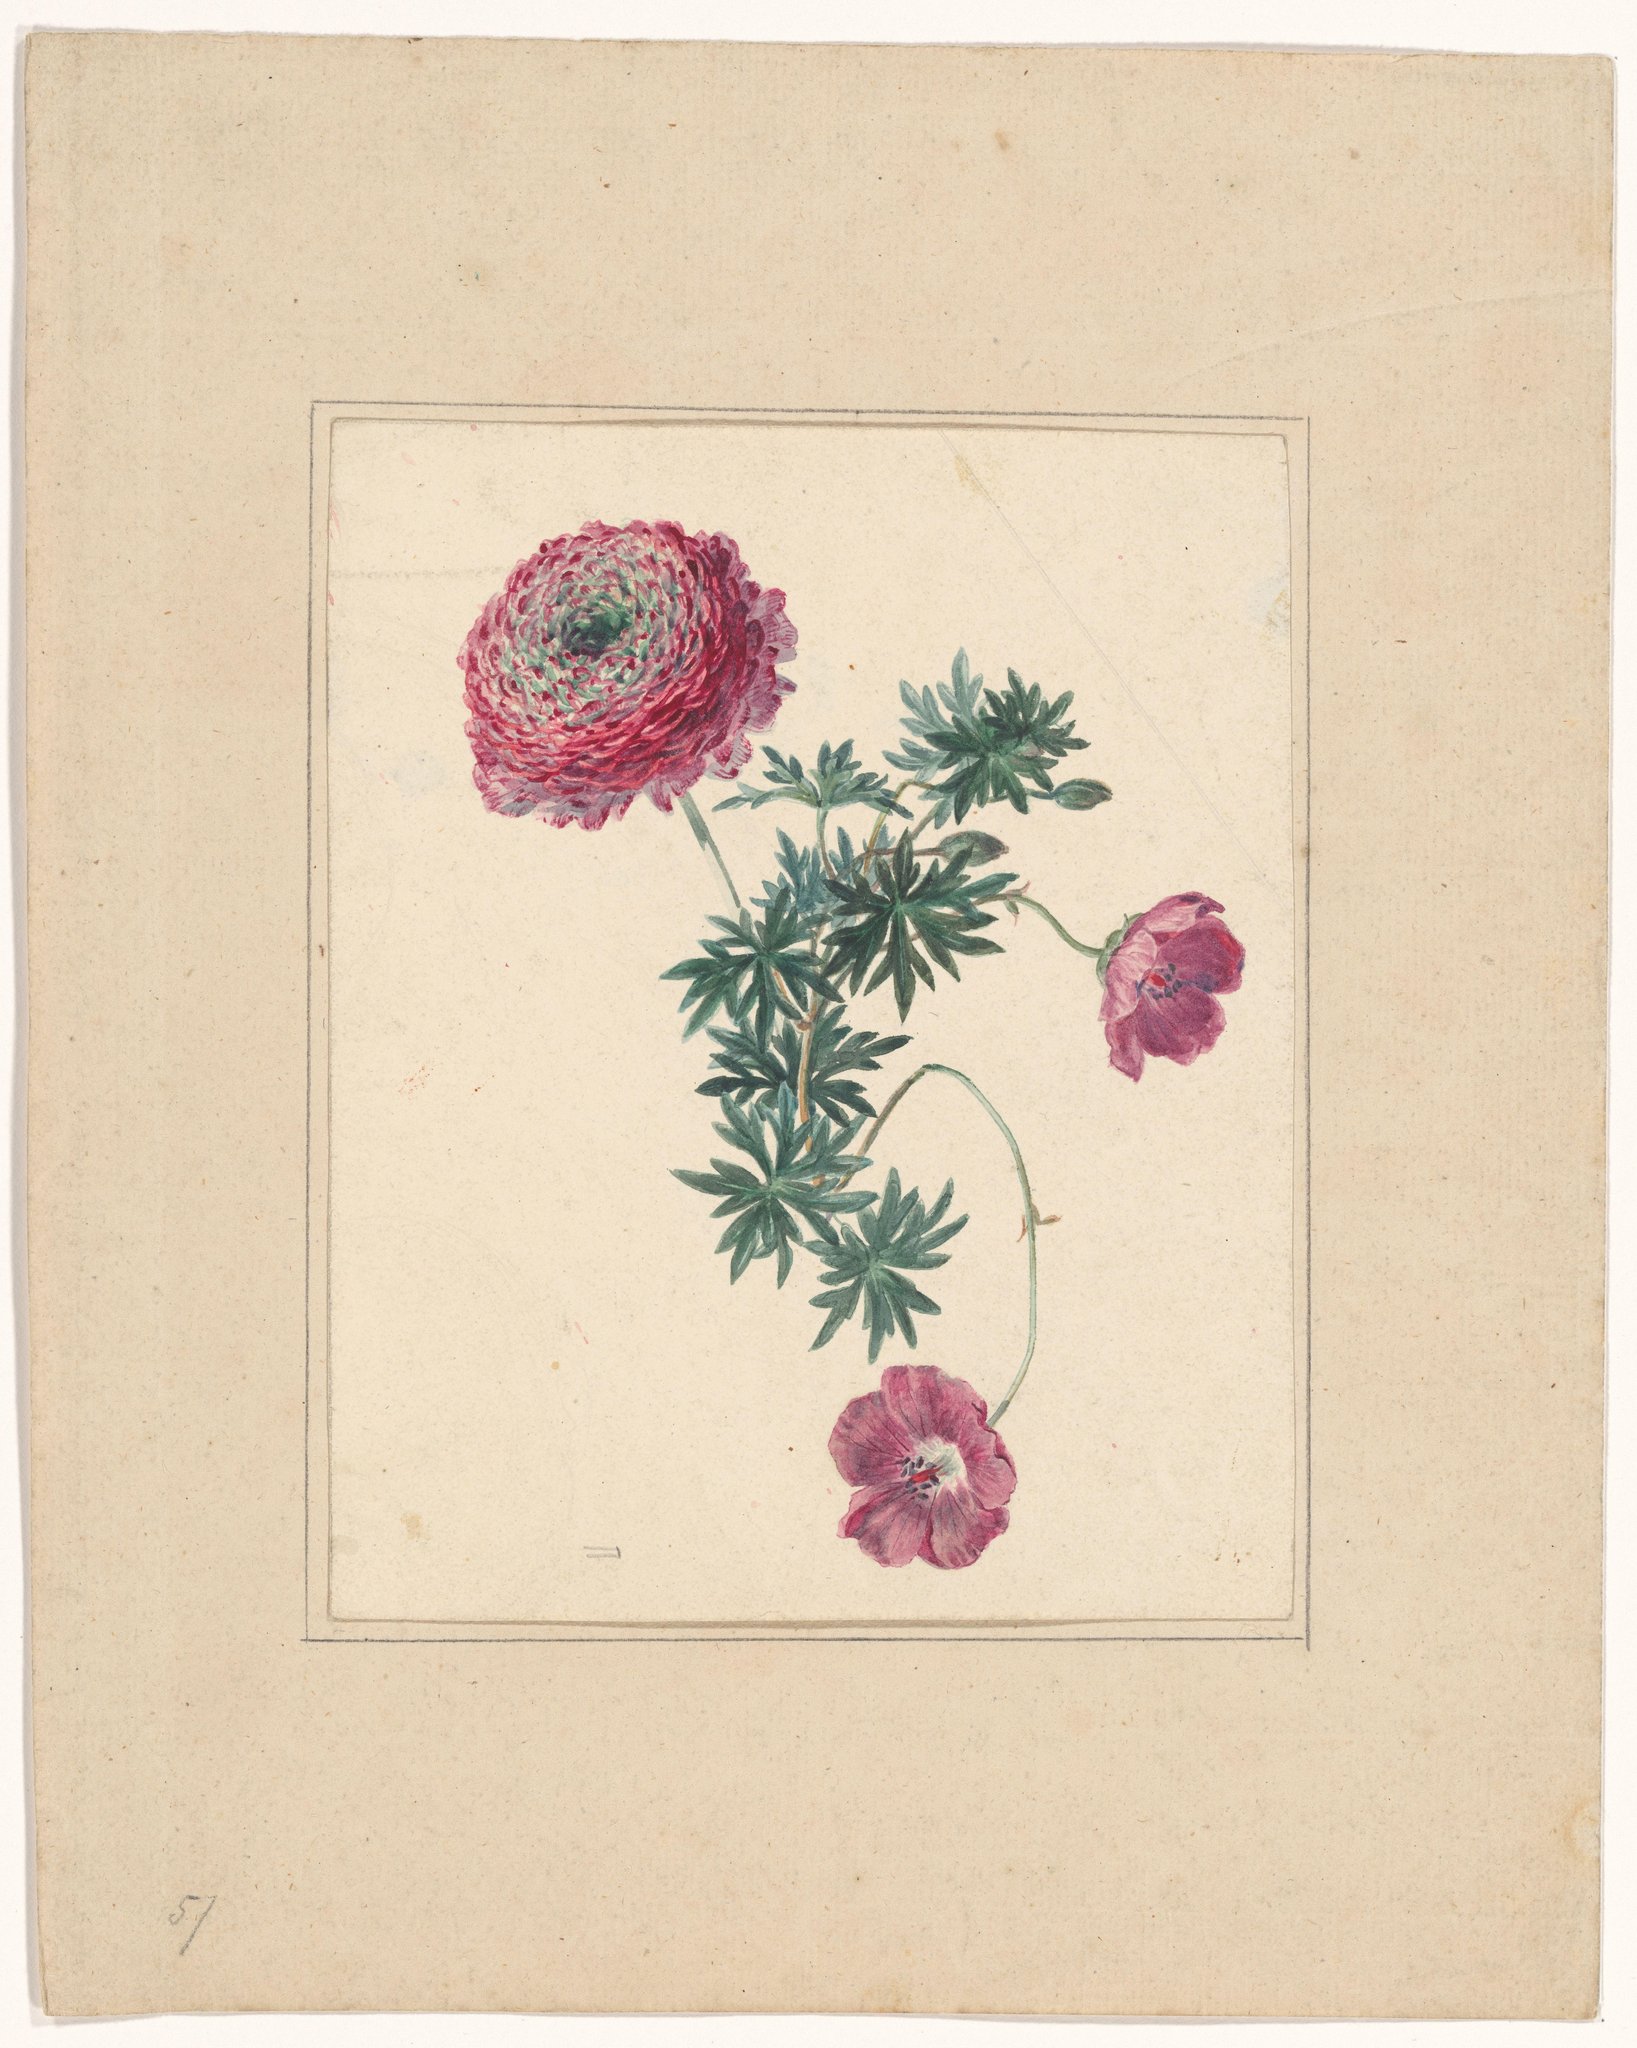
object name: drawing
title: Bloedooievaarsbek?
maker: Anonymous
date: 1815-1830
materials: paper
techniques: drawing